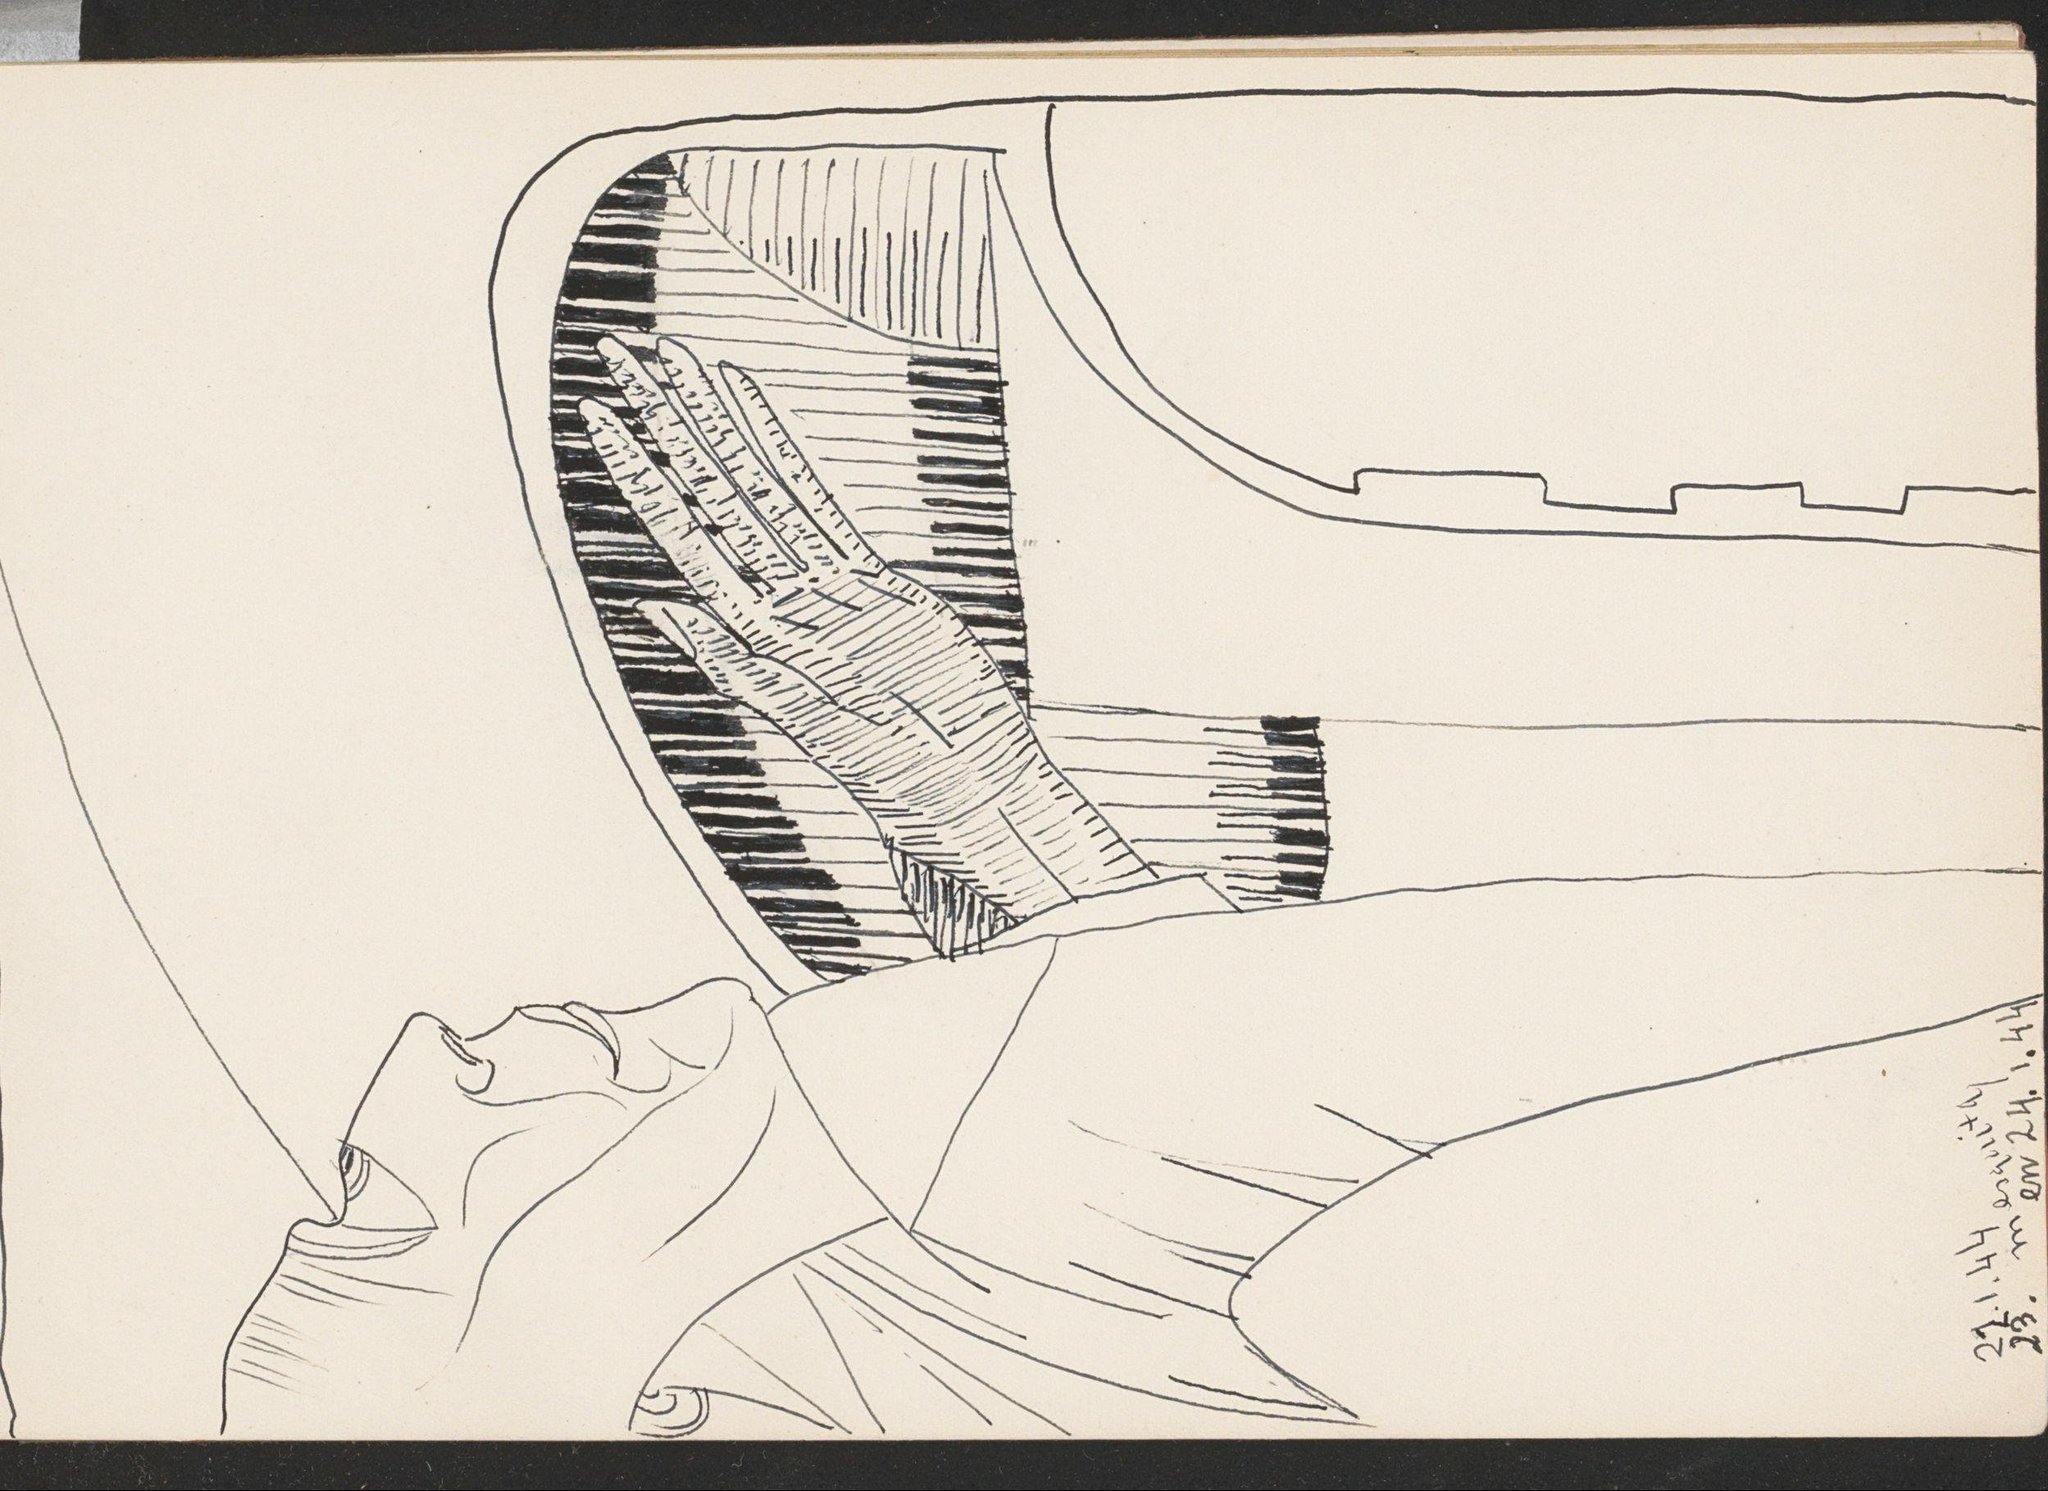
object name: sketchbook leaf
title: Man in profiel naar rechts met de linkerhand opgeheven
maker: samuel jessurun de mesquita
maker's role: draughtsman, print maker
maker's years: 1868-1944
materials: ink, paper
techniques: pen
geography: amsterdam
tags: adult man, arm stretched forward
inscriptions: signature and date: ‘22.1.44/23. mesquita/ en 24.1.44’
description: De man heeft de hand opgeheven voor een half-ovale met daarin rijen pianotoetsen. Blad 16 recto uit een schetsboek met 18 bladen.